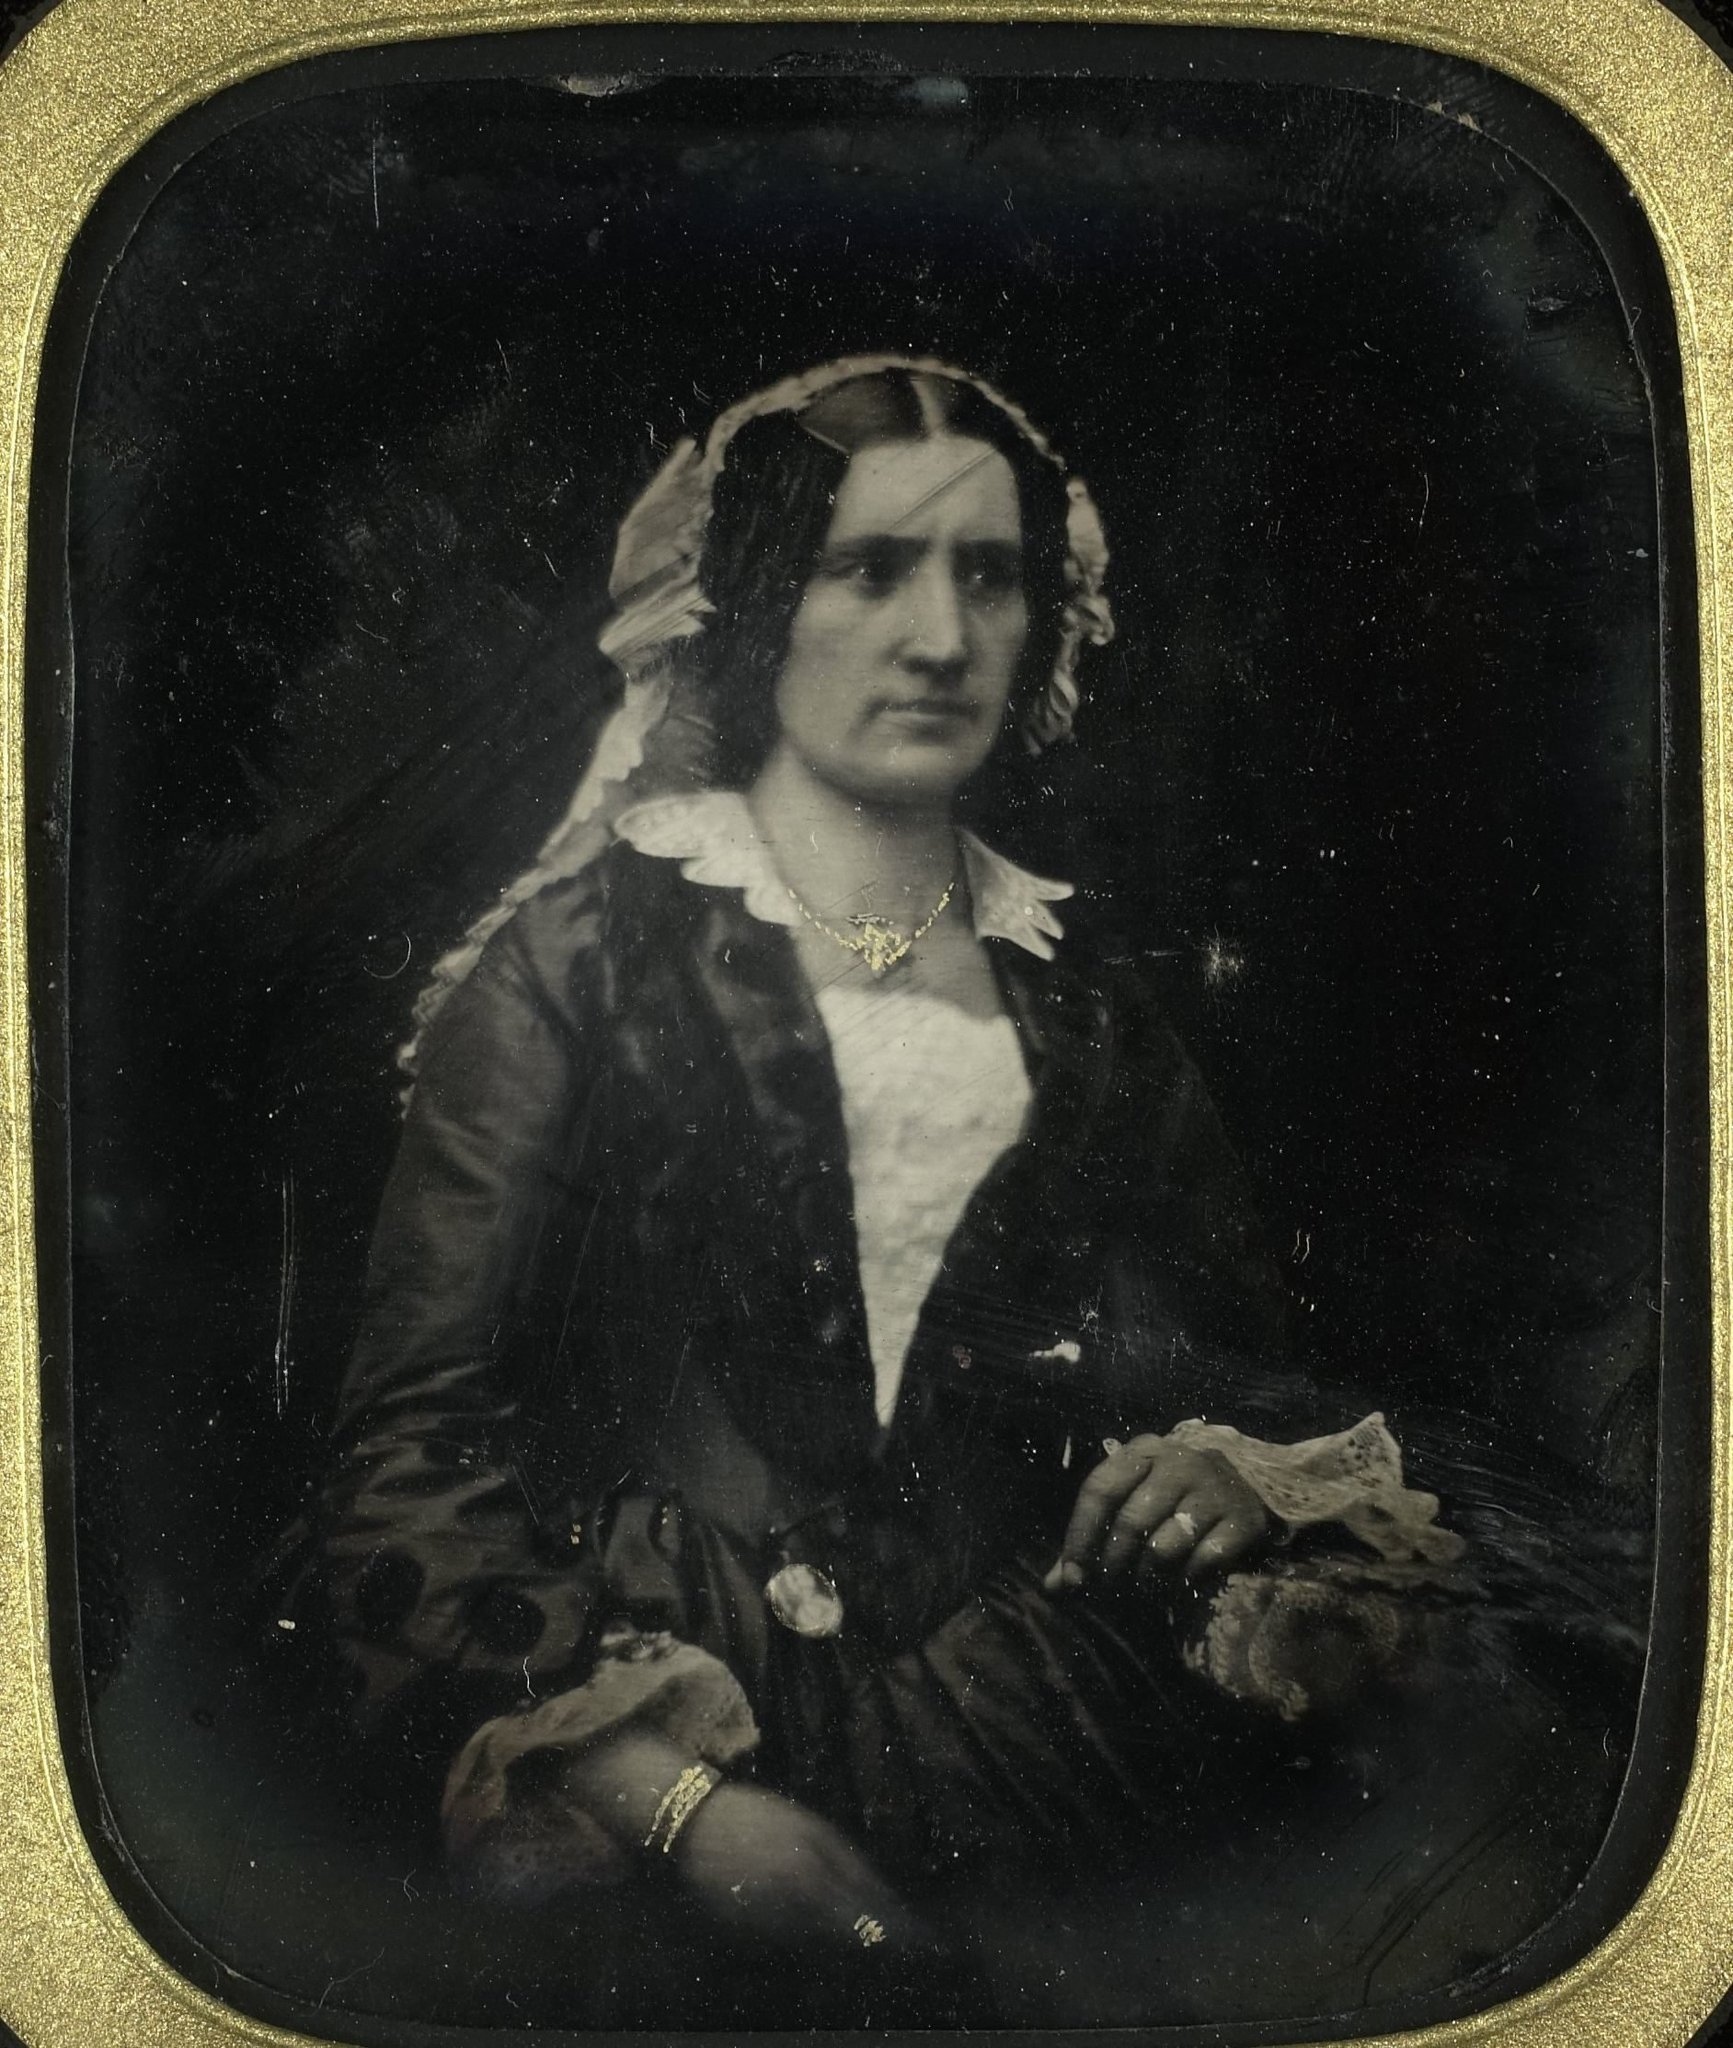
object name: photograph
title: Portret van een onbekende vrouw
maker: j.l. ussing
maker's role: fotograaf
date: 1840-1860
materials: copper, glass, paper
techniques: daguerreotype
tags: adult man, historical persons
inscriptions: inscription: ‘J. L. Ussing’